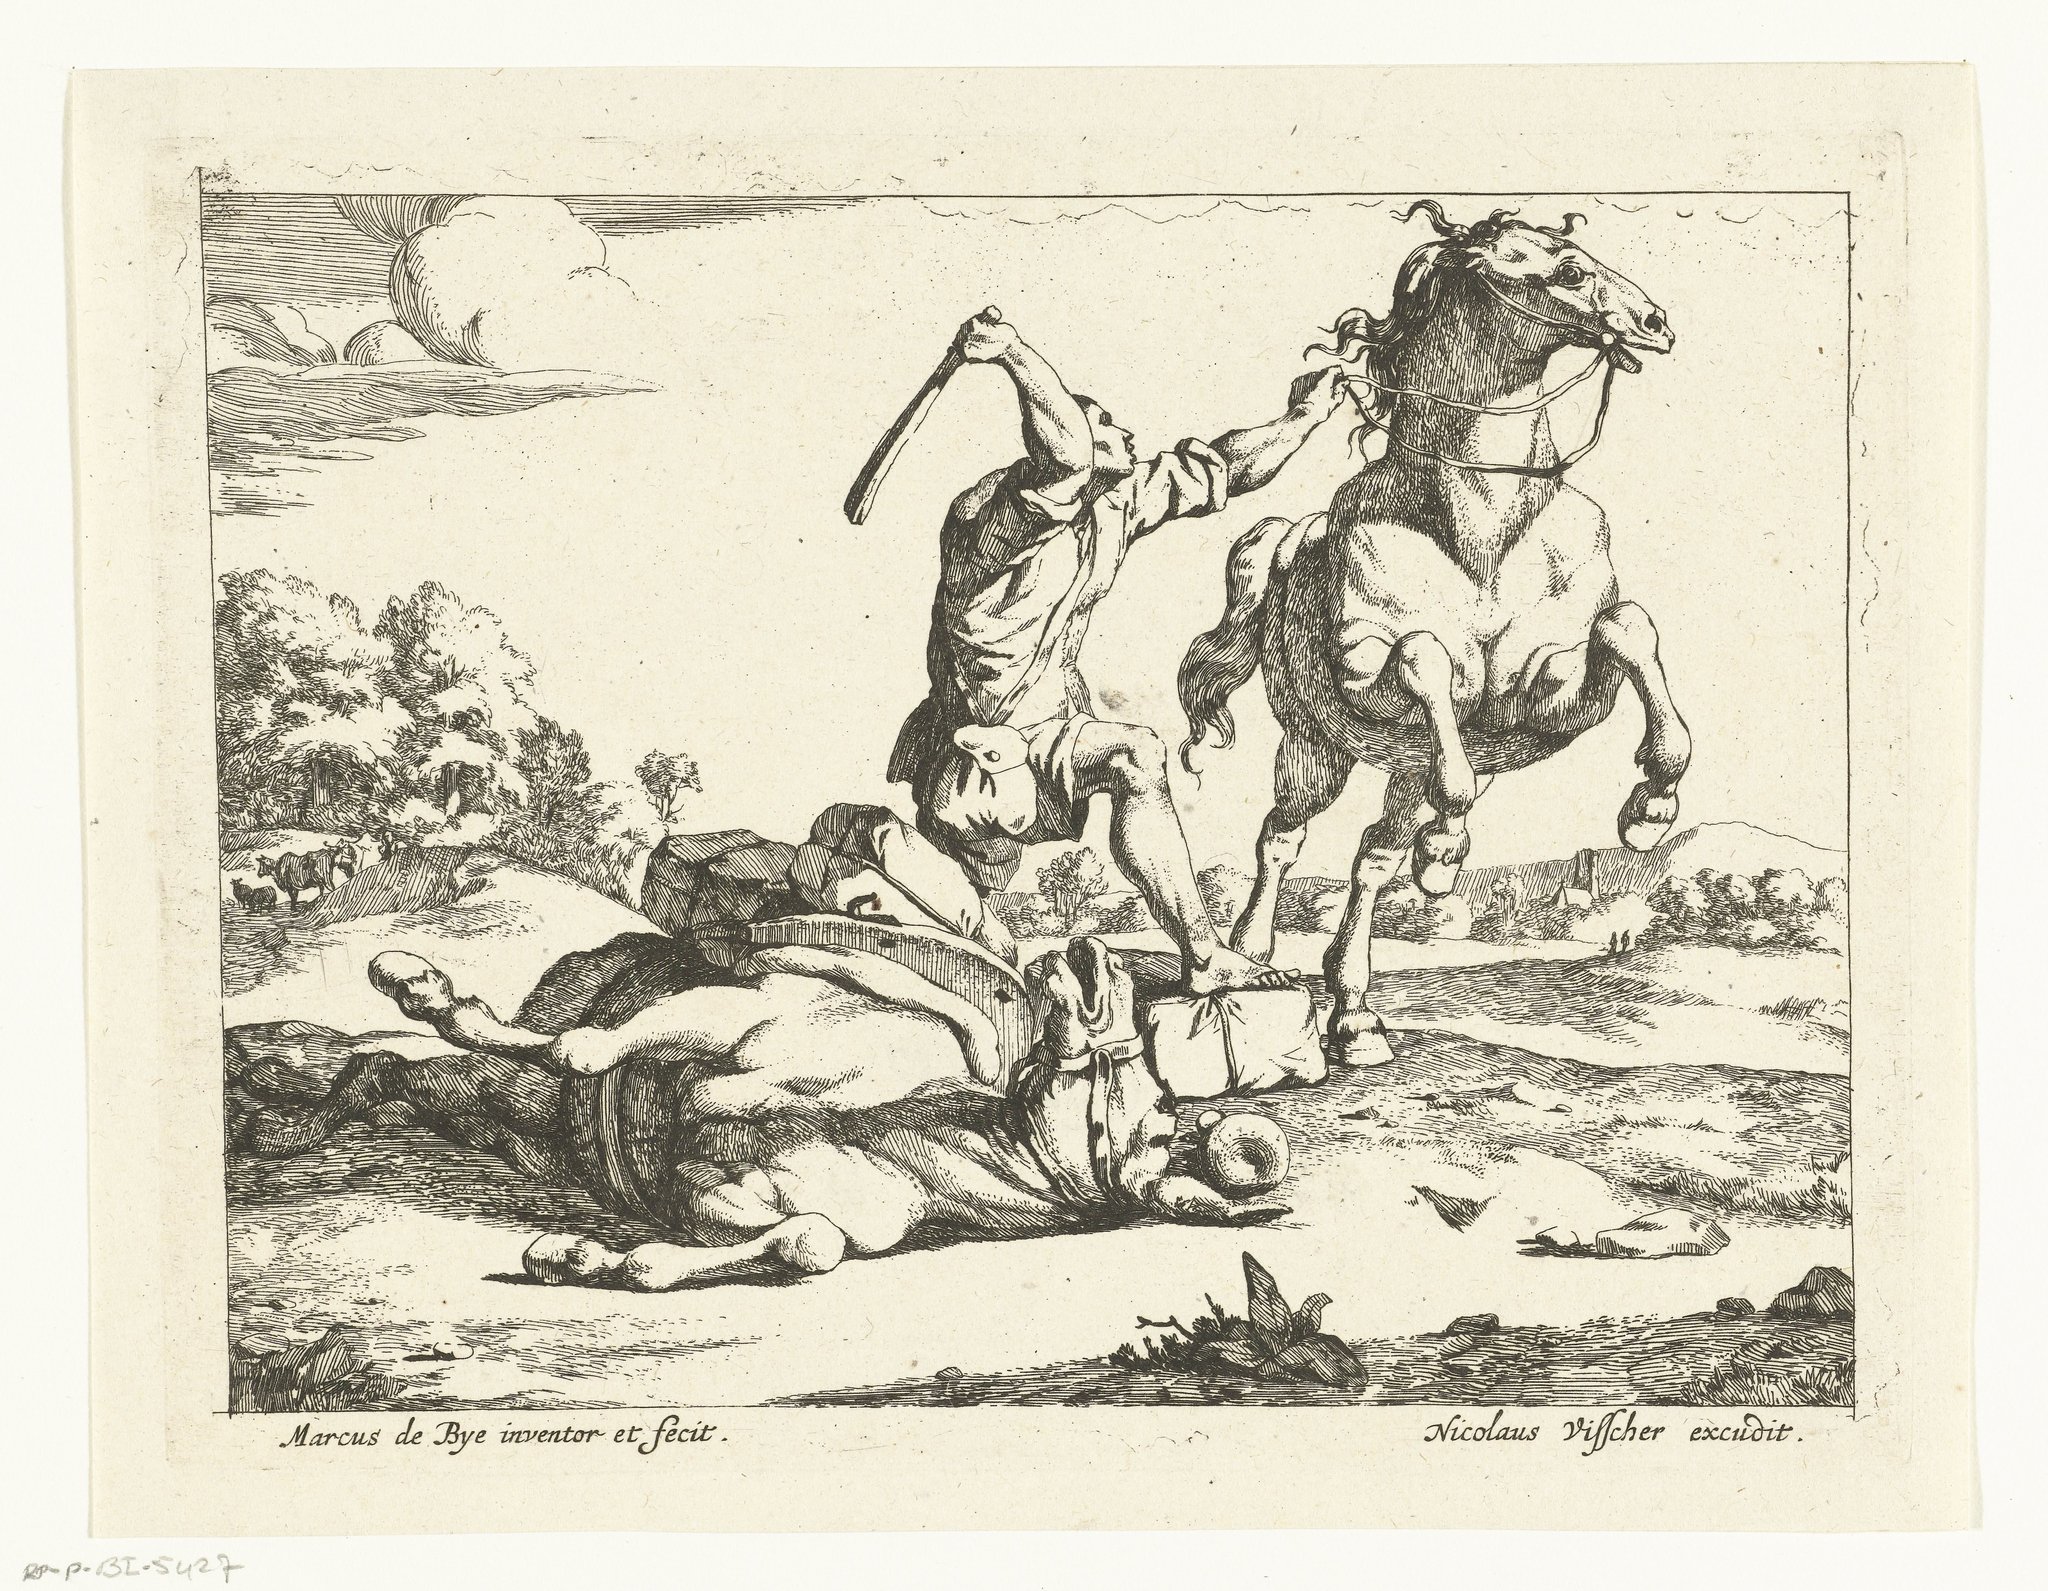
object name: print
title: Muilezeldrijver slaat een paard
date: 1657-1677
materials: paper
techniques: etching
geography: the hague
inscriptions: collector's mark: Lugt 2228